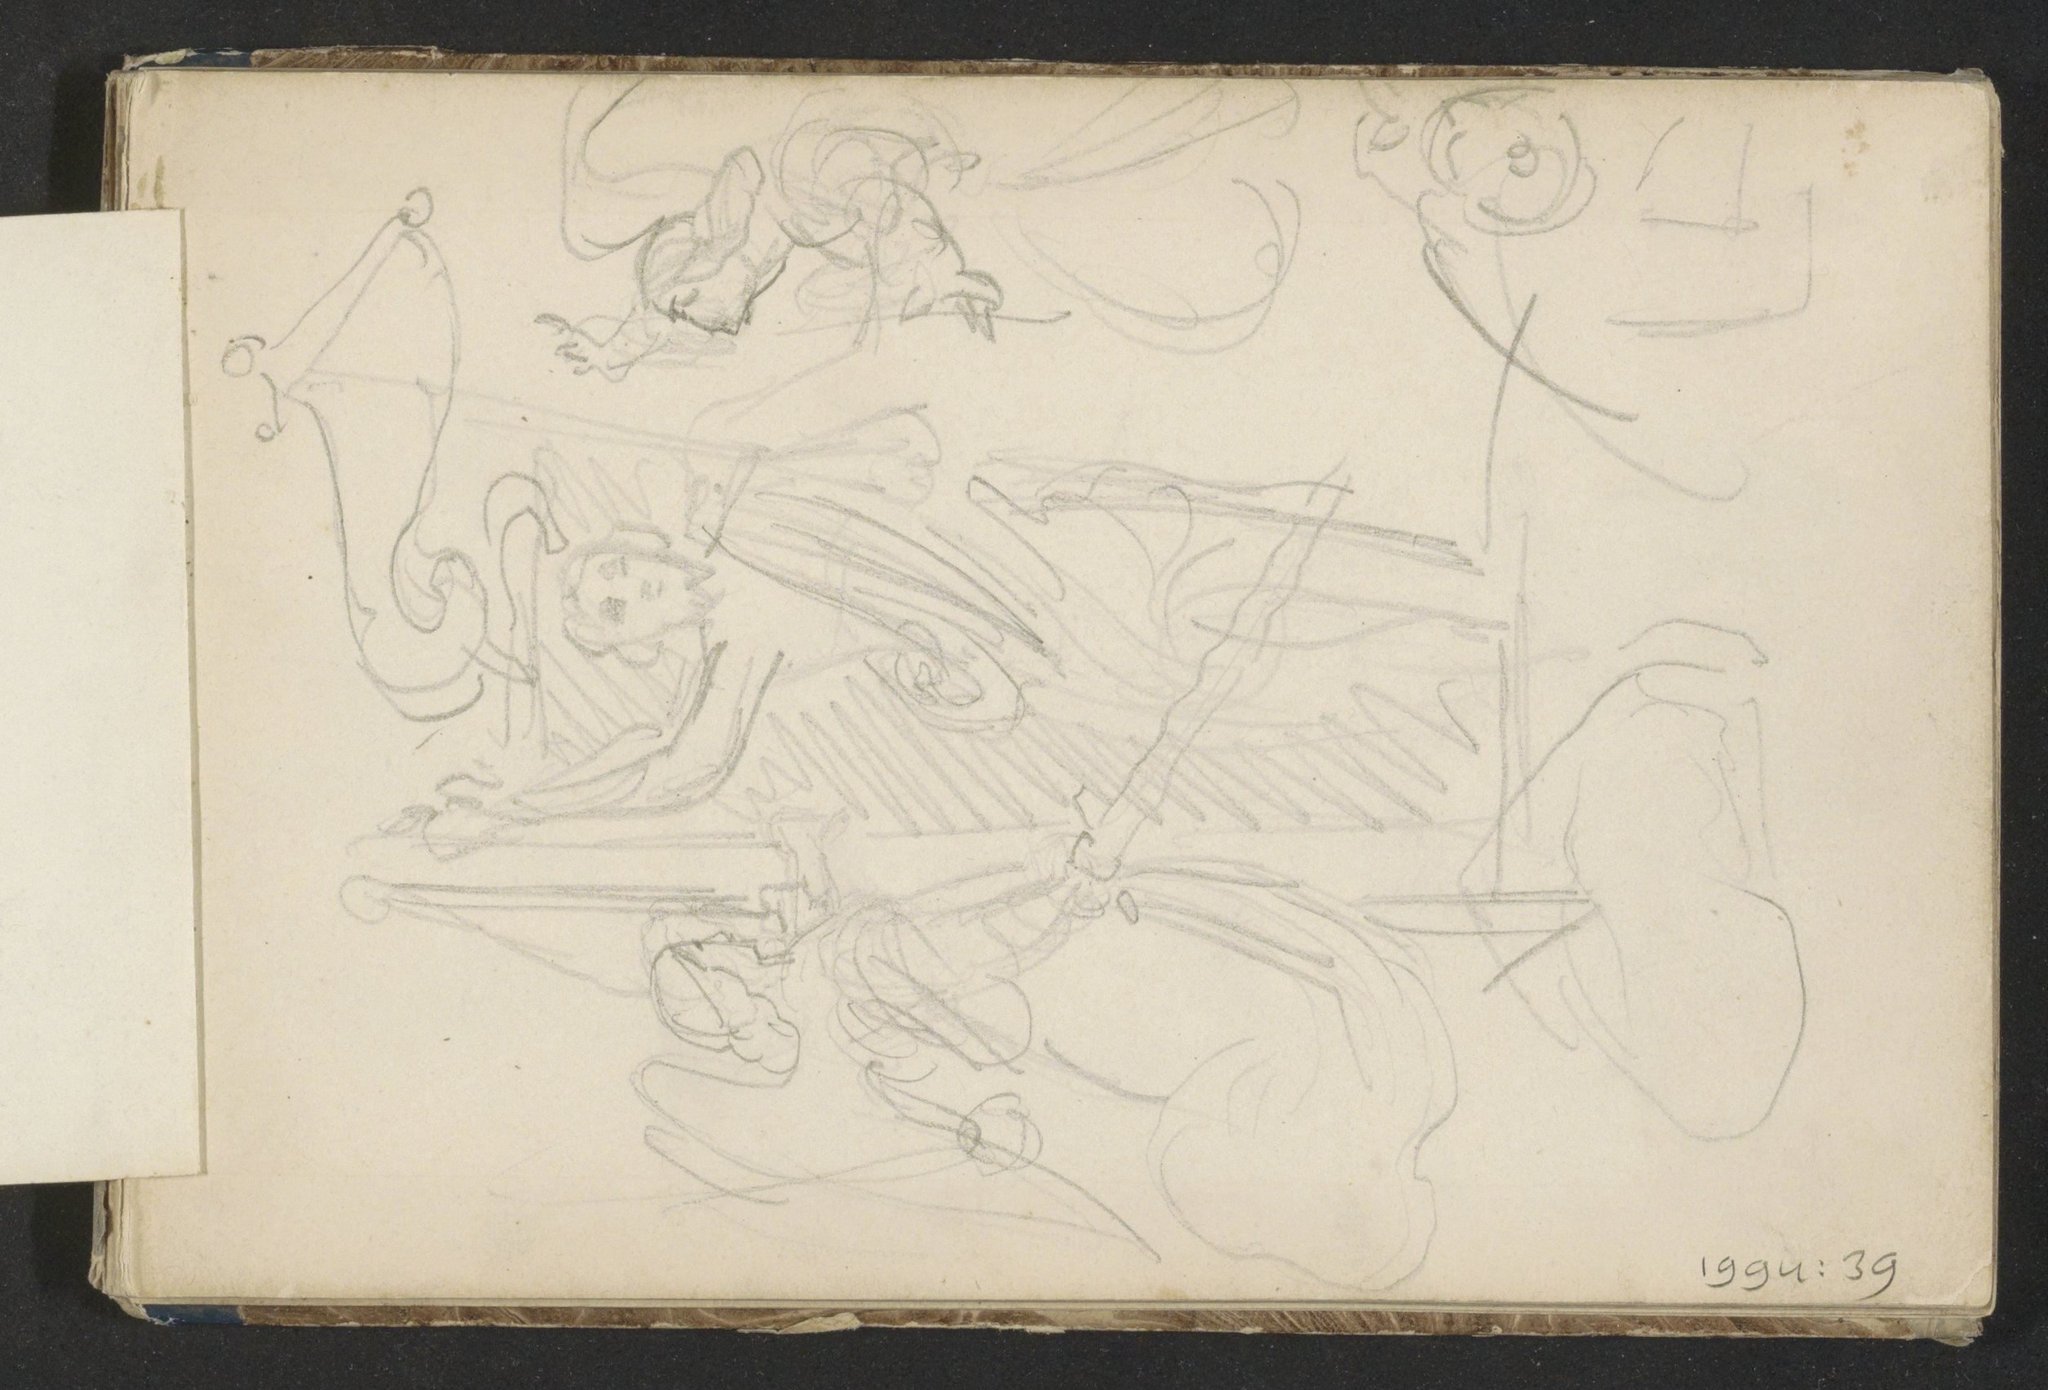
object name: sketchbook leaf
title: Opstanding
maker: Anonymous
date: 1841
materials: paper, pencil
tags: christ, usually holding a banner, arises from the grave; often combined with sleeping and/or frightened soldiers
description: Blad 2 recto uit een schetsboek met 33 bladen.